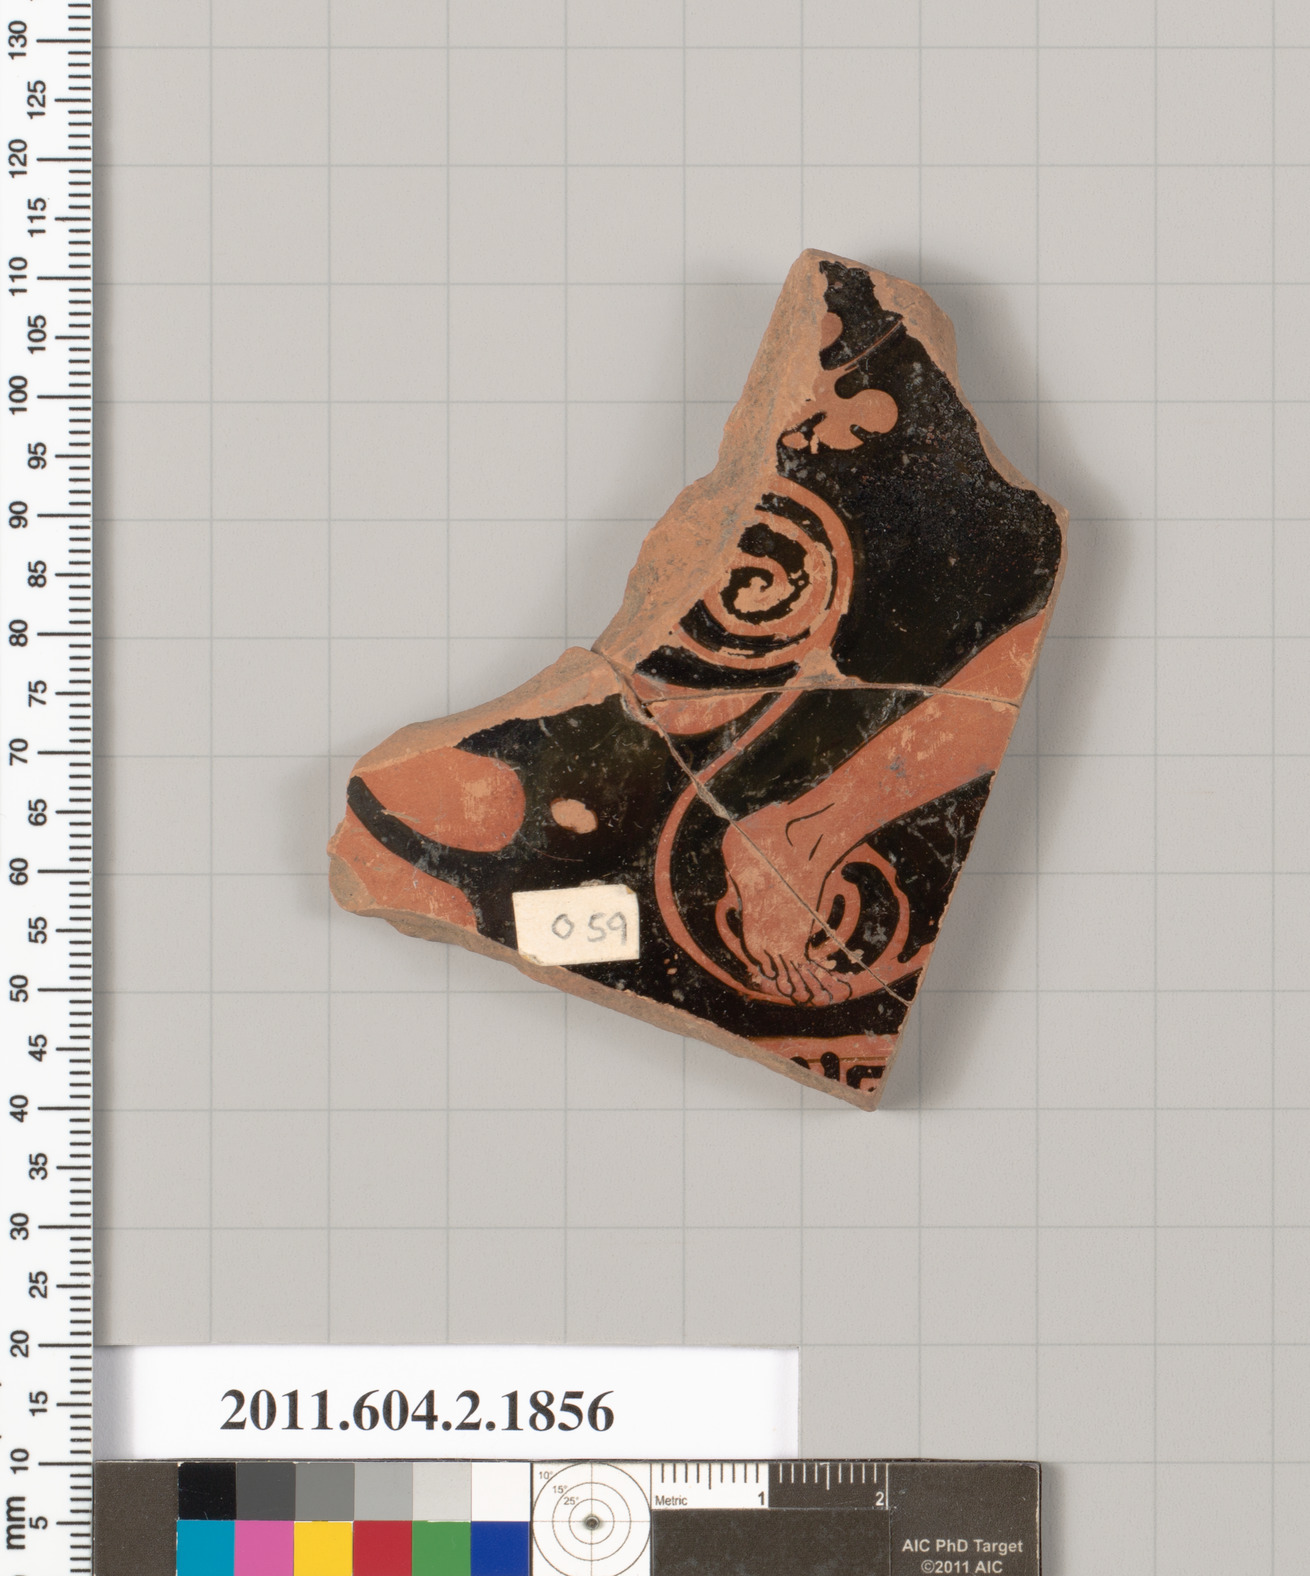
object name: skyphos fragment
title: Terracotta fragment of a skyphos (deep drinking cup)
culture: greek, attic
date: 460-450 BCE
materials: terracotta